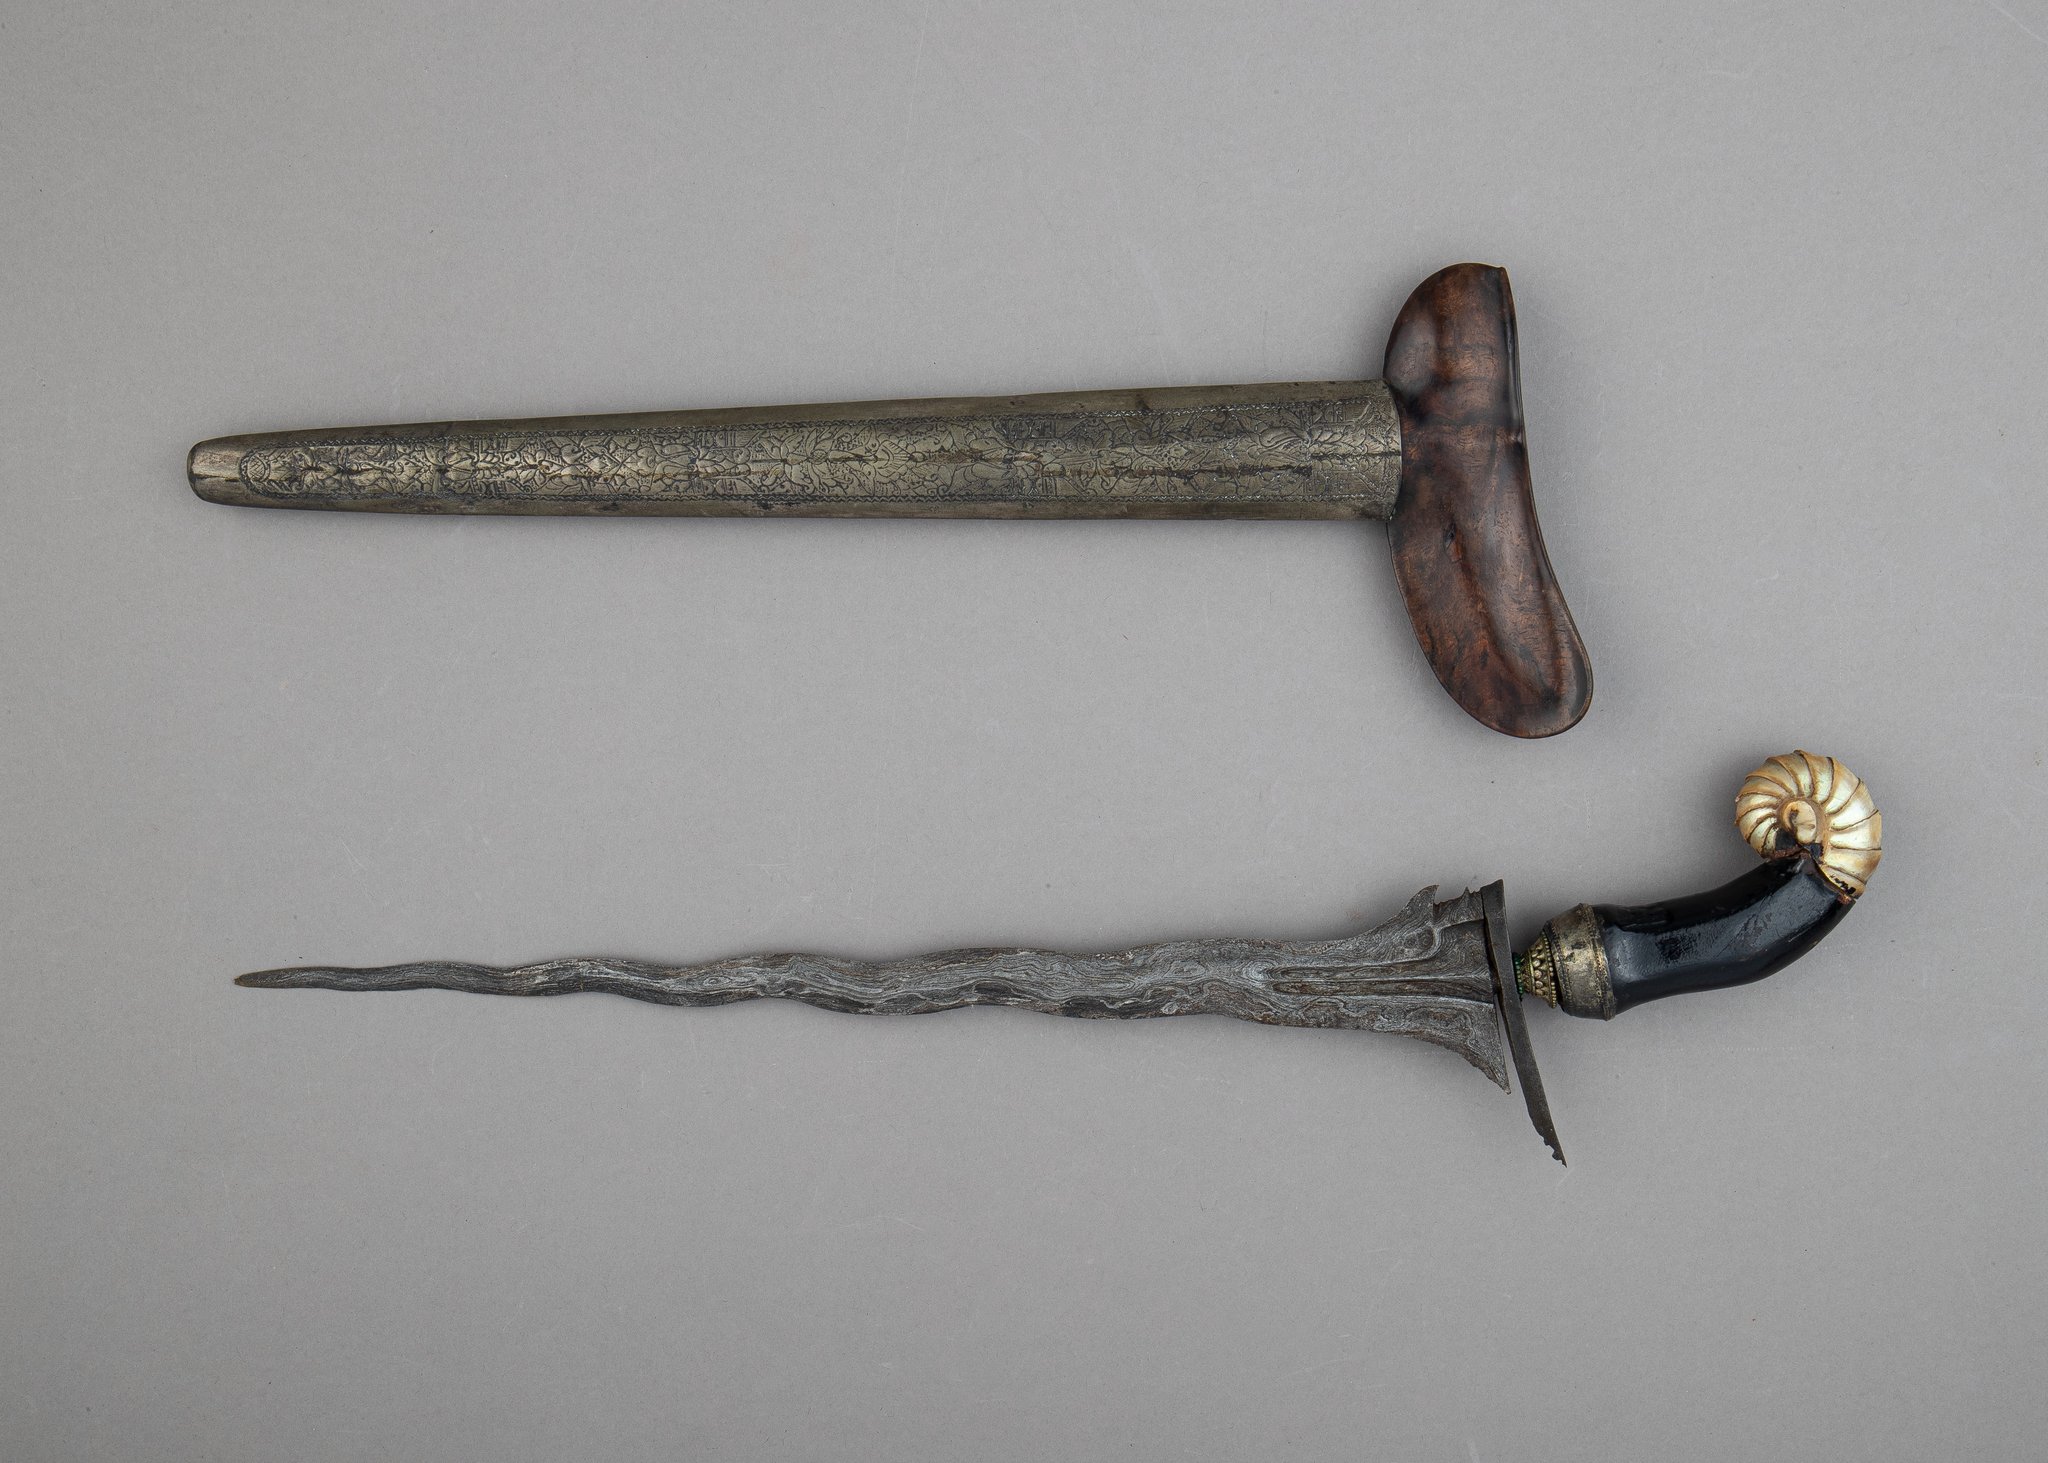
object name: kris with sheath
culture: javanese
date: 1501-1900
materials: copper alloy, shell, silver, steel, wood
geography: indonesia